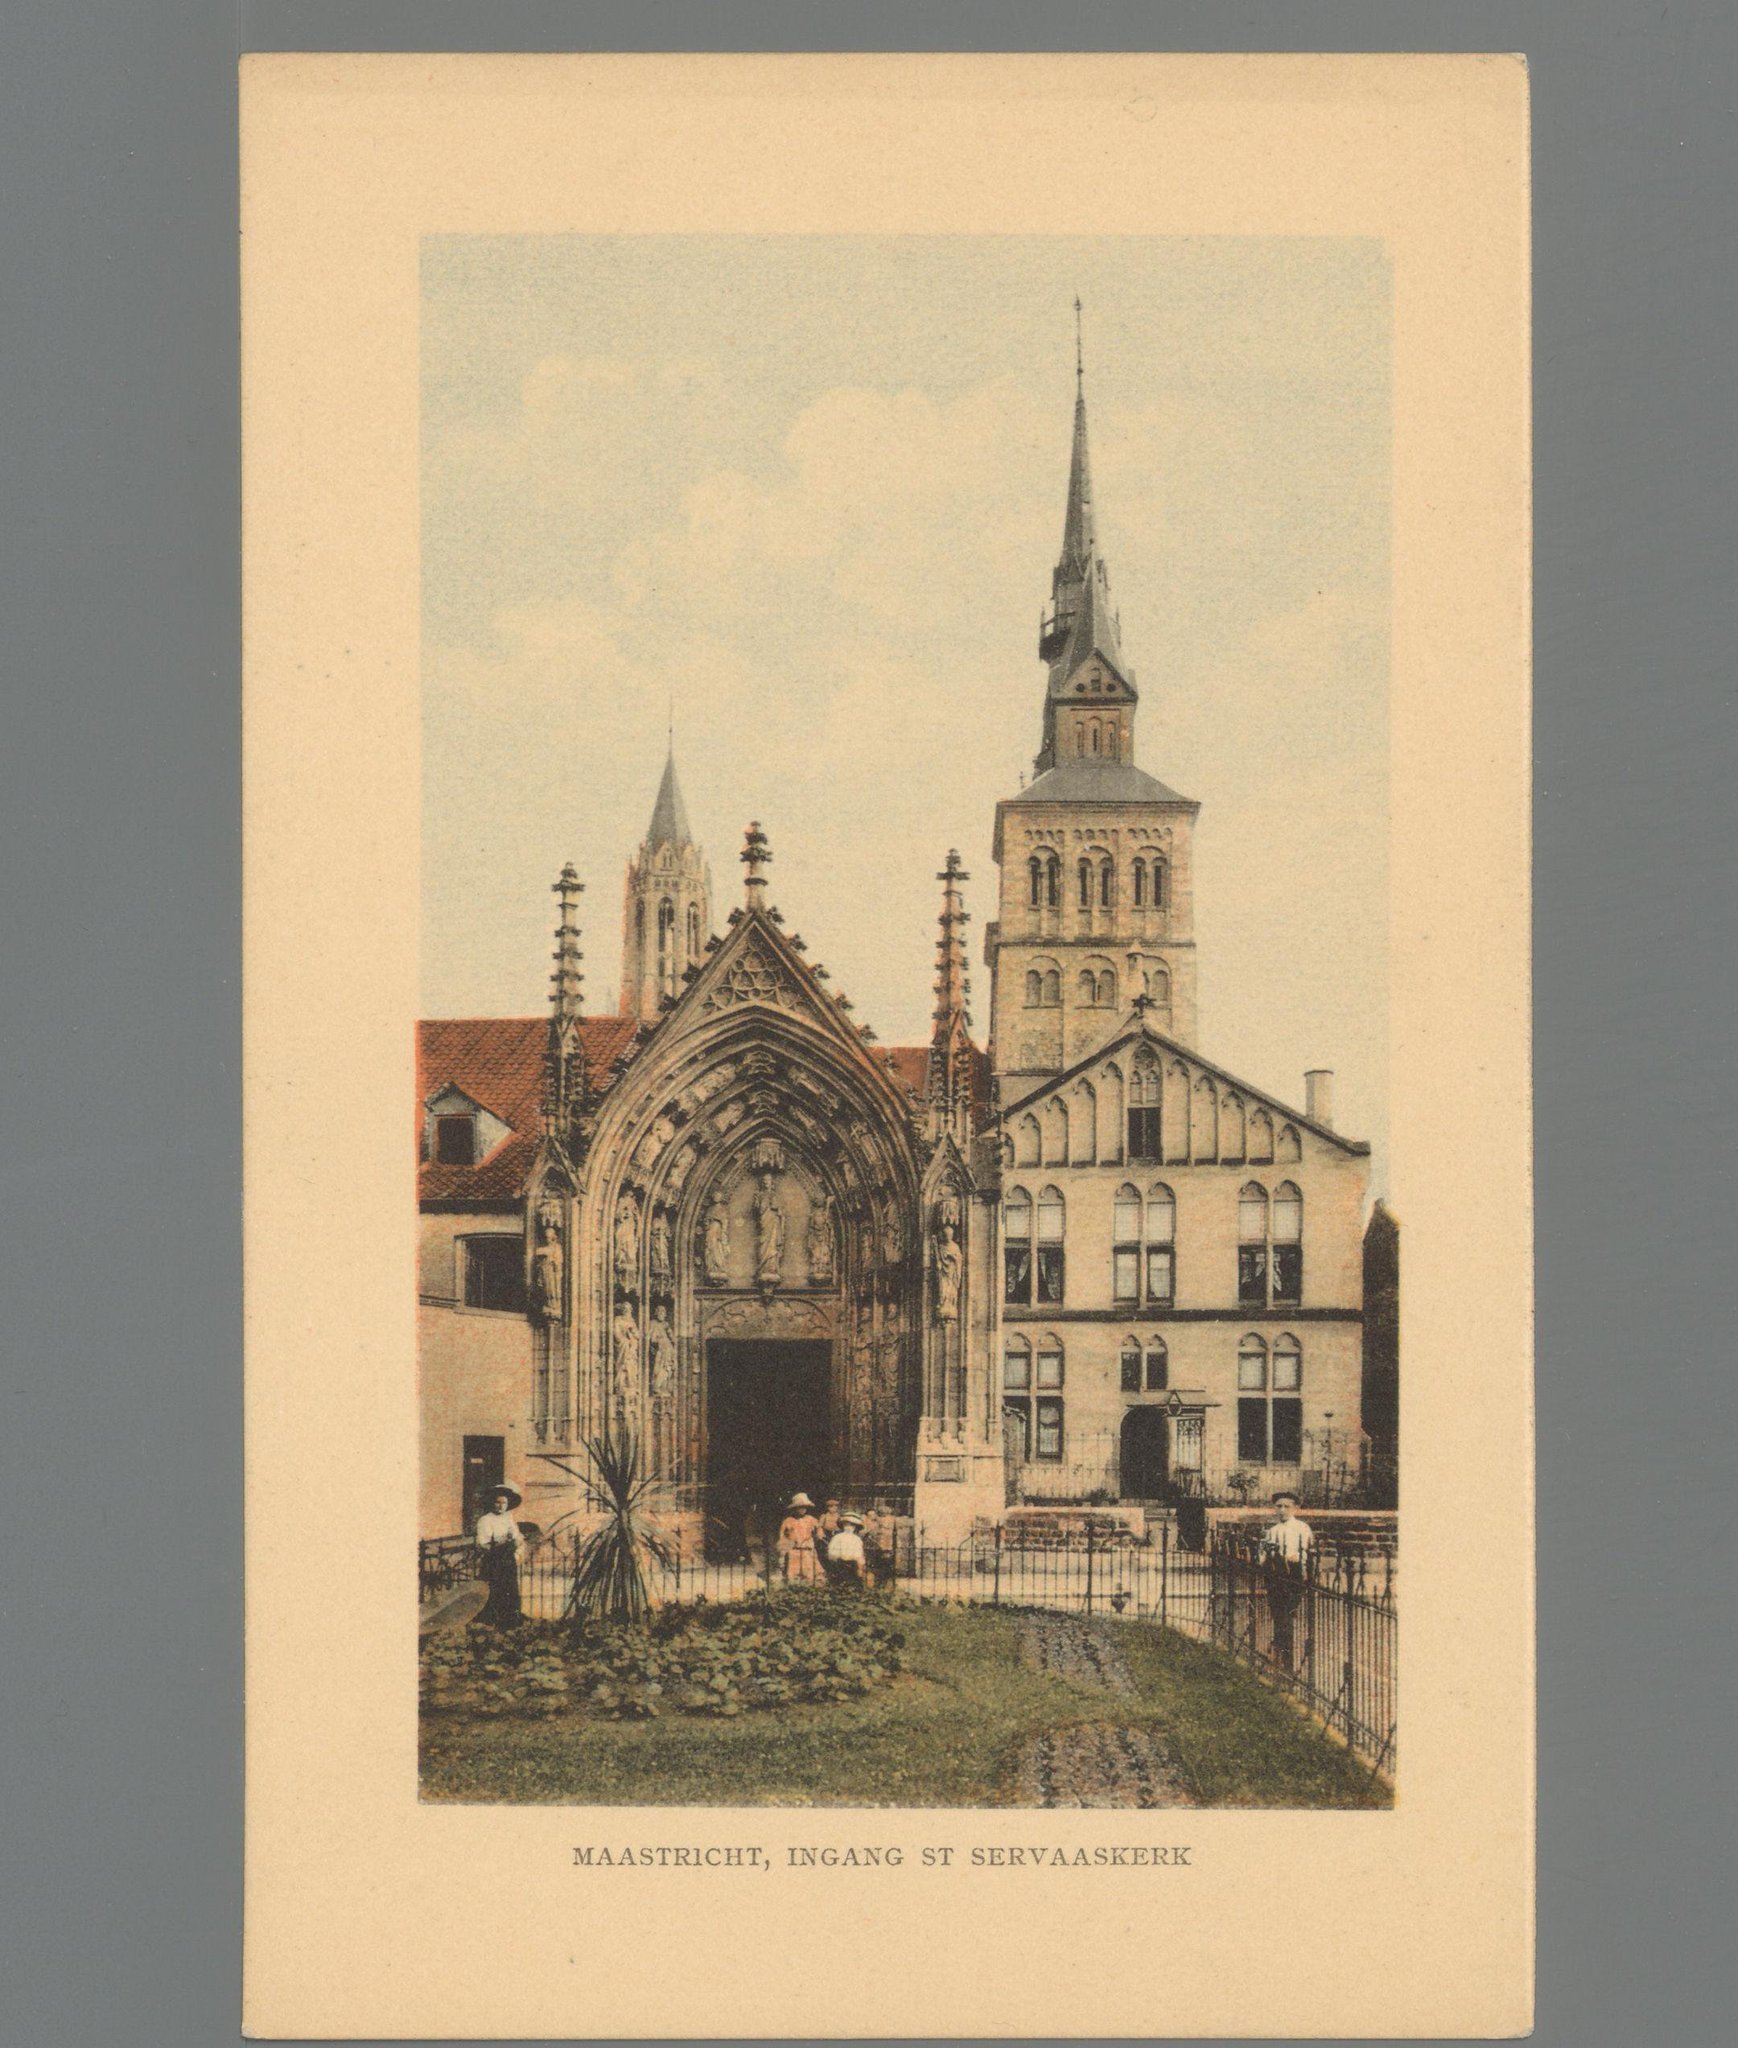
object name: ansichtkaart, prentbriefkaart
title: Maastricht, ingang St Servaaskerk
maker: Anonymous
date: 1905-1920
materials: cardboard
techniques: collotype process, lithograph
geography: maastricht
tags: church (exterior), gate, entrance